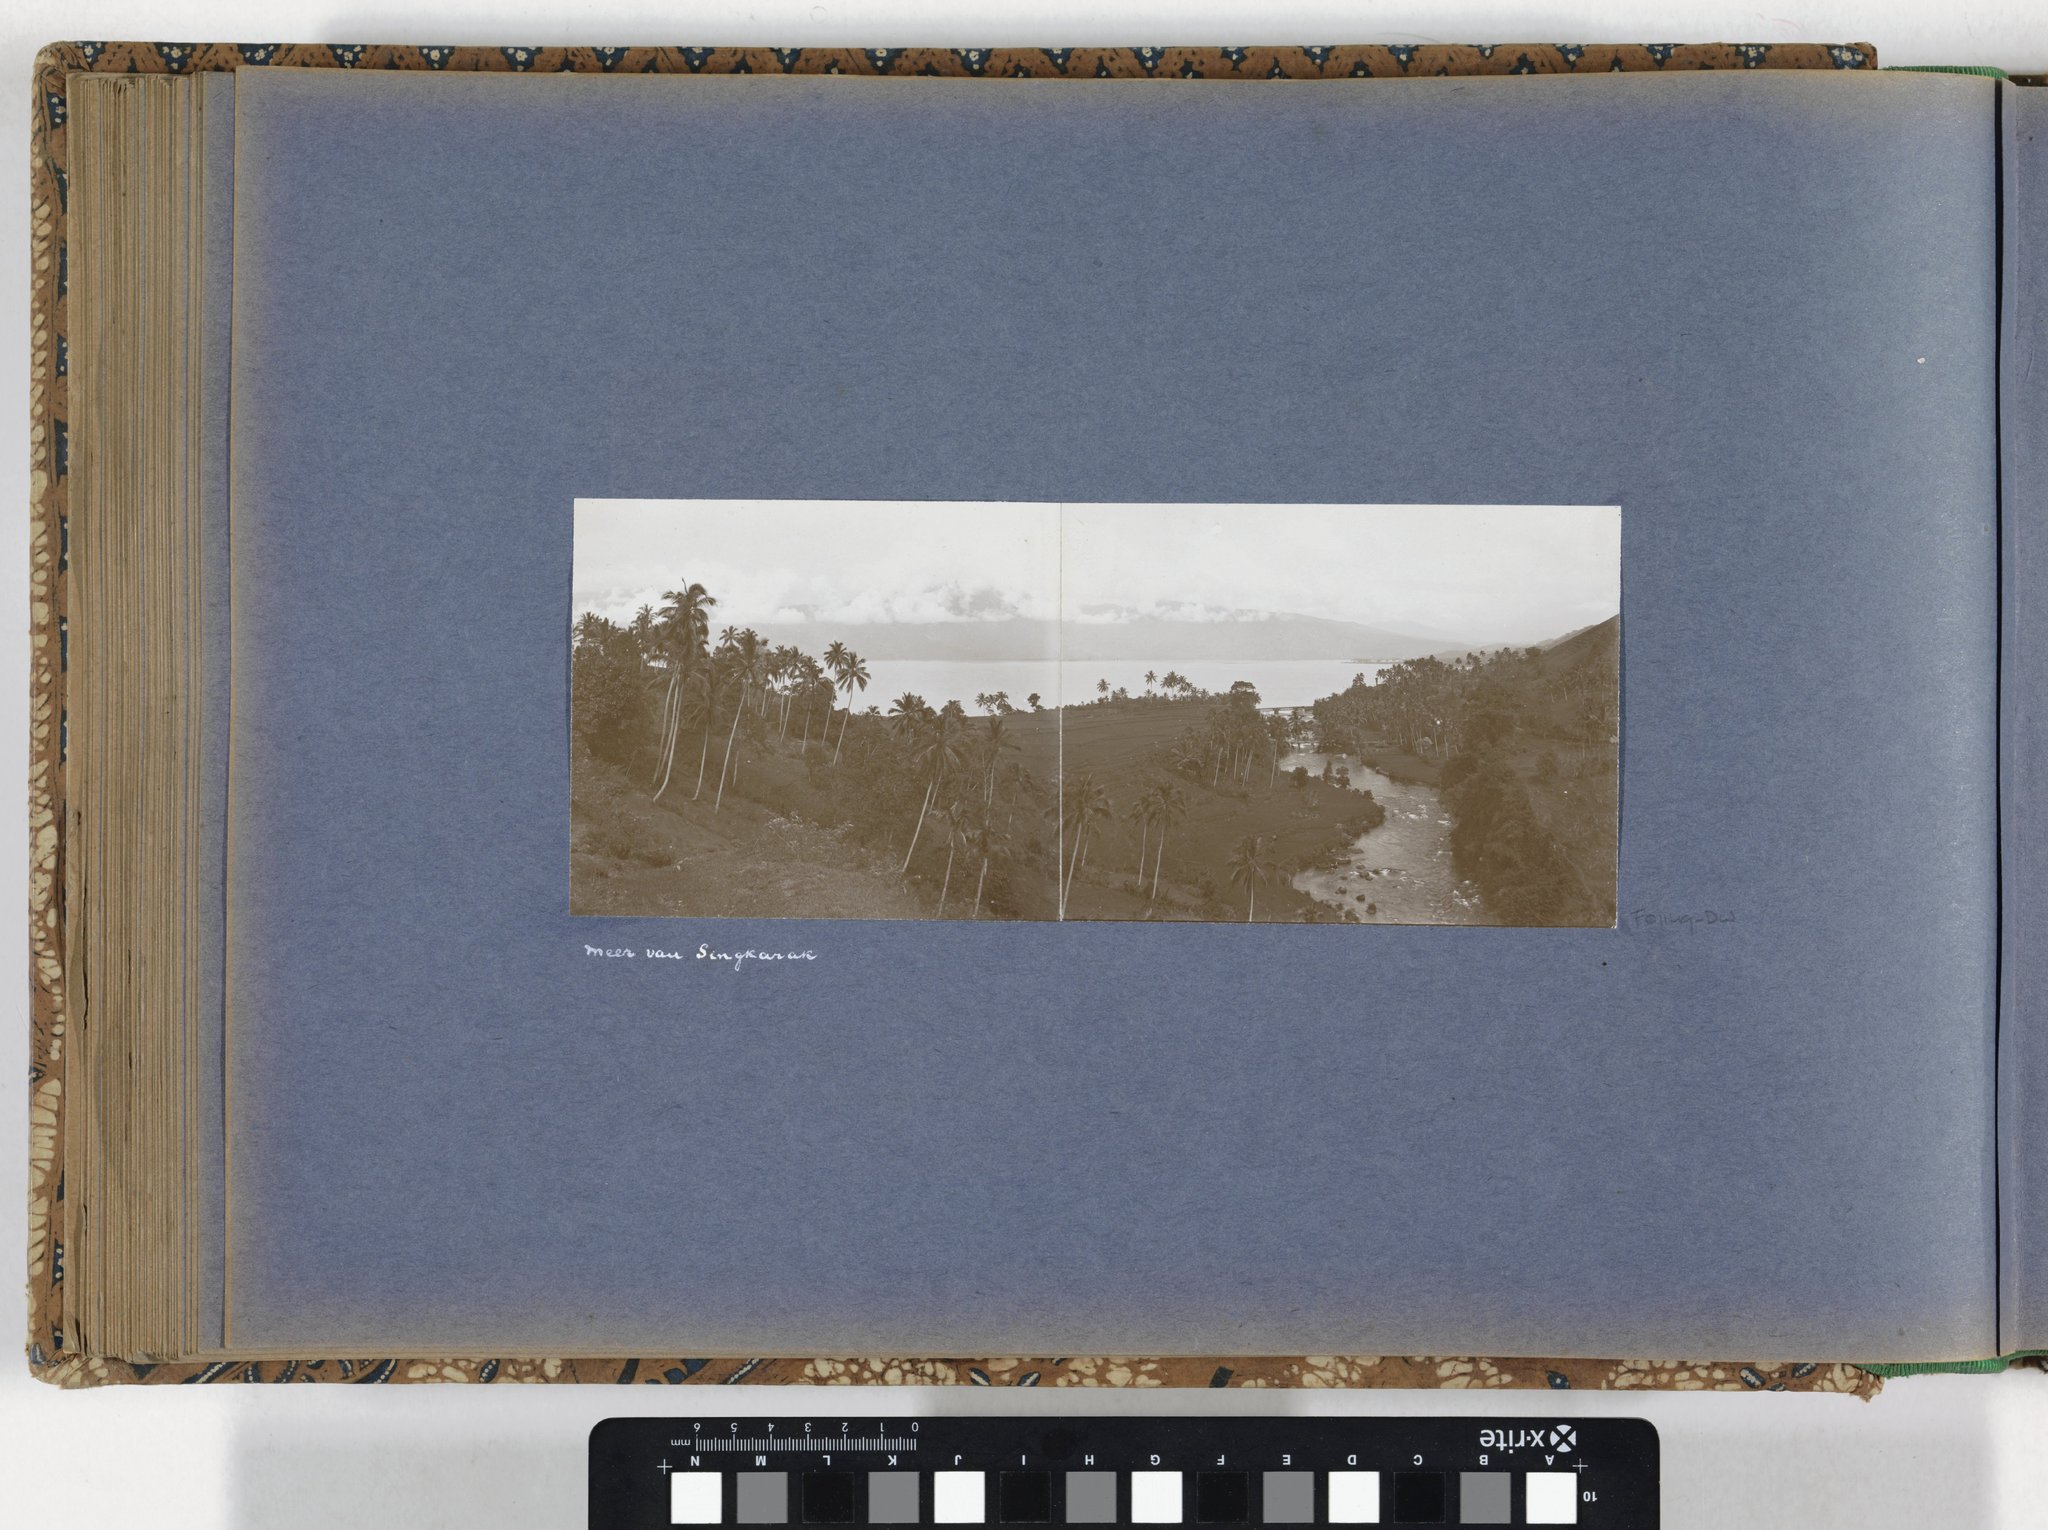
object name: album leaf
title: Gezicht op de uitmonding van de Oembilienrivier in het Singkarakmeer op Sumatra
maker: Anonymous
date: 1900-1920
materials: paper, photographic support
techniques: gelatin silver print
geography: sumatra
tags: river, lake, sumatra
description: Panoramafoto bestaande uit twee afdrukken. Onderdeel van reisalbum met foto's van bedrijvigheid en bezienswaardigheden op Sumatra en Java en van de reis naar en van Nederlands-Indië.